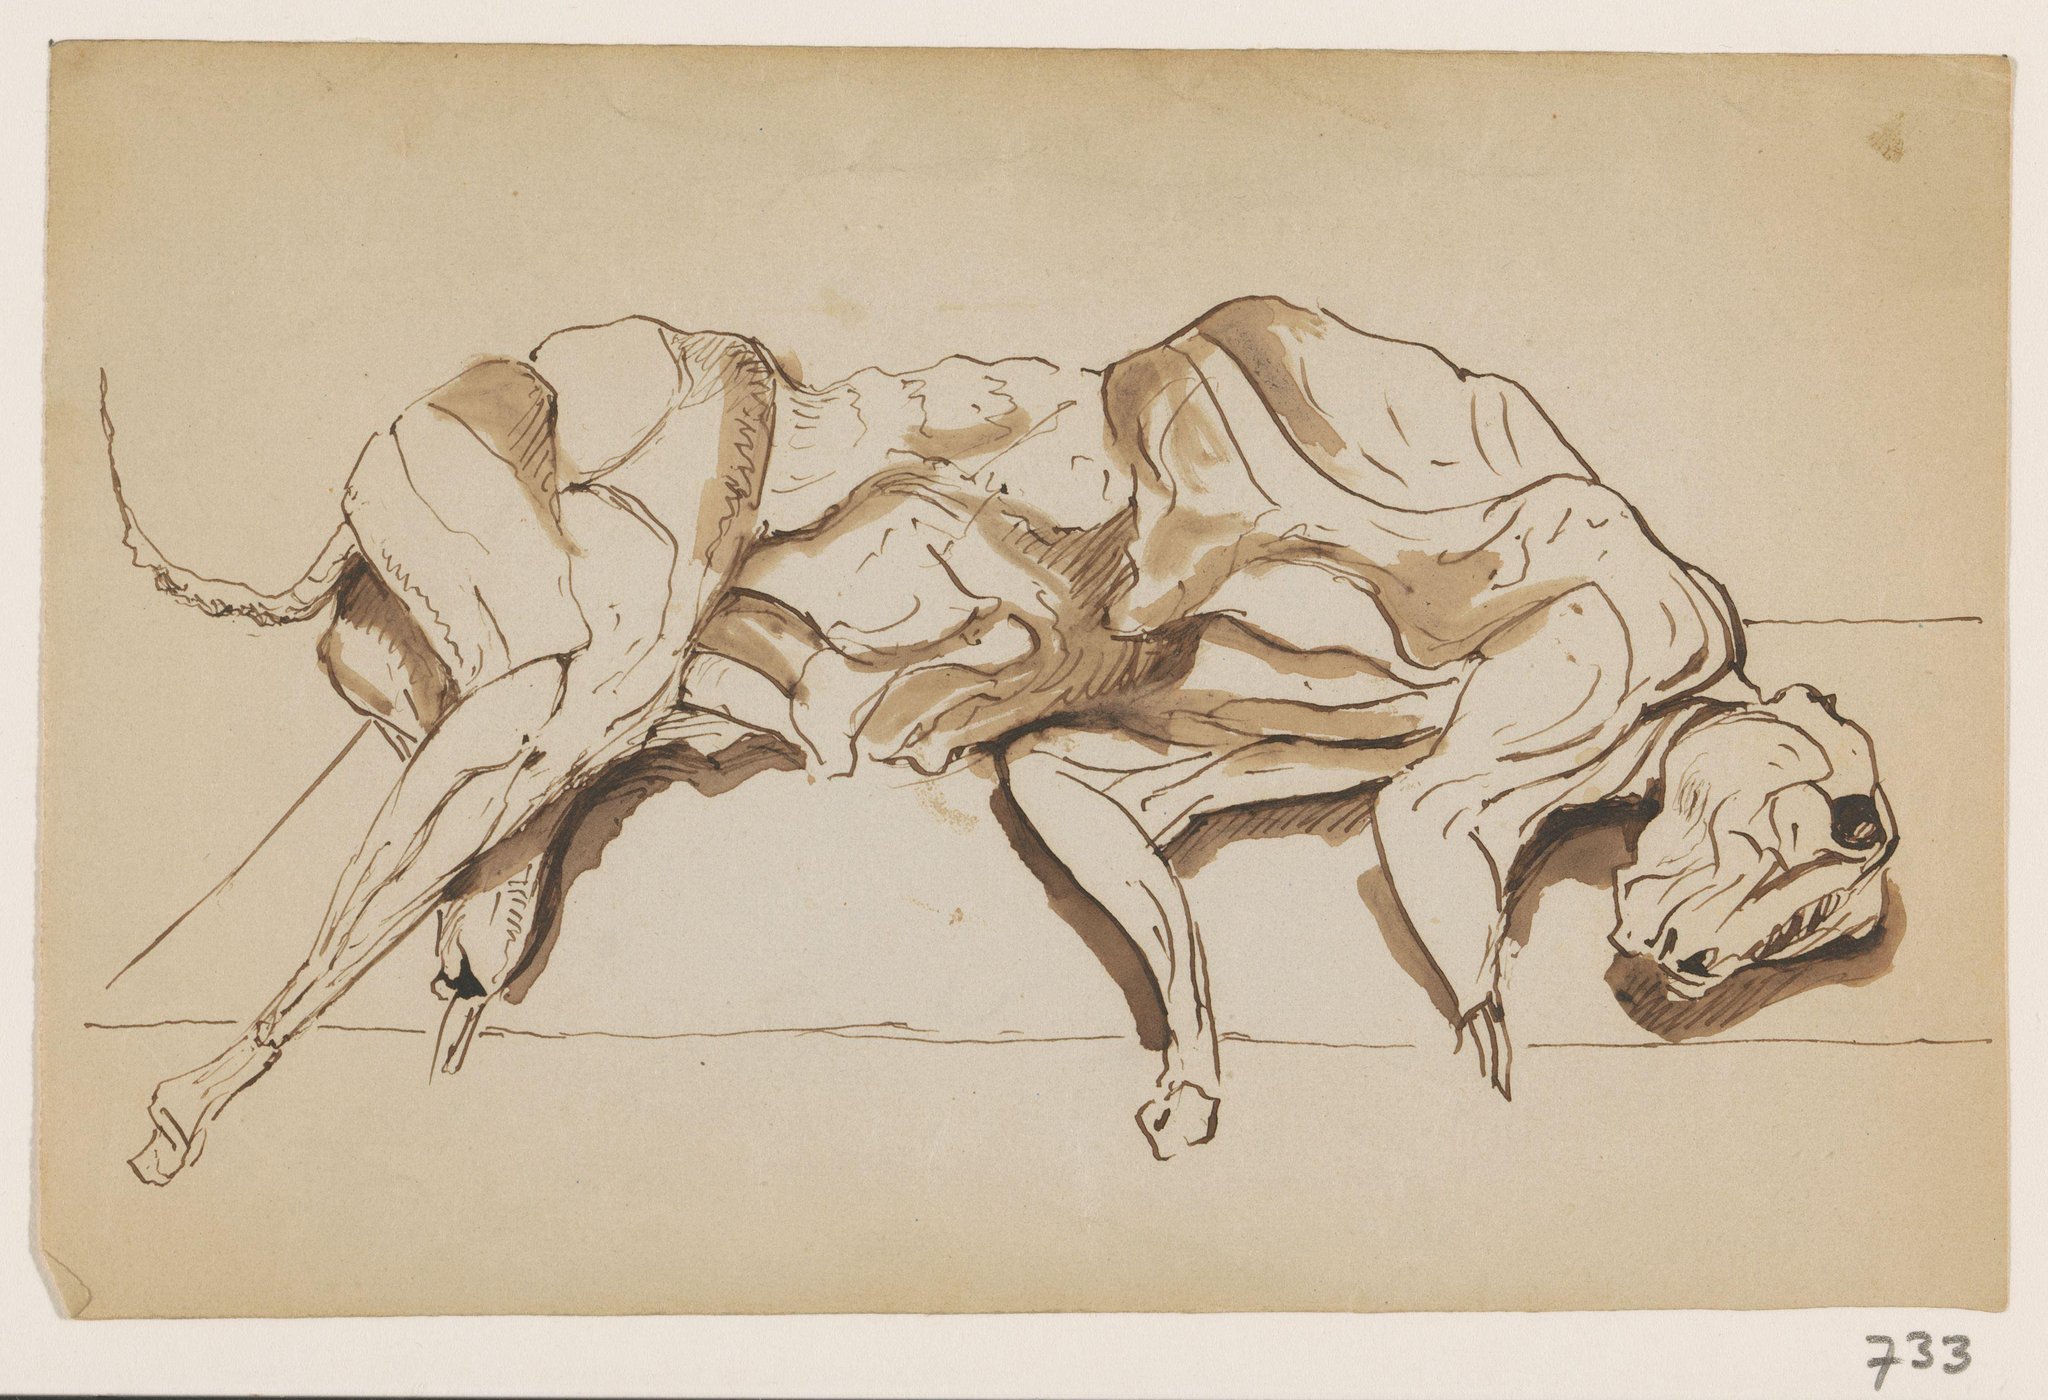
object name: drawing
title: Karkas van een dier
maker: johannes tavenraat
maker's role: draughtsman, painter, print maker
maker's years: 1809-1881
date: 1840-1880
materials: ink, paper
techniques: brush, pen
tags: mammals (+ disease and death of animal(s))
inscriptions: collector's mark: Lugt 2228